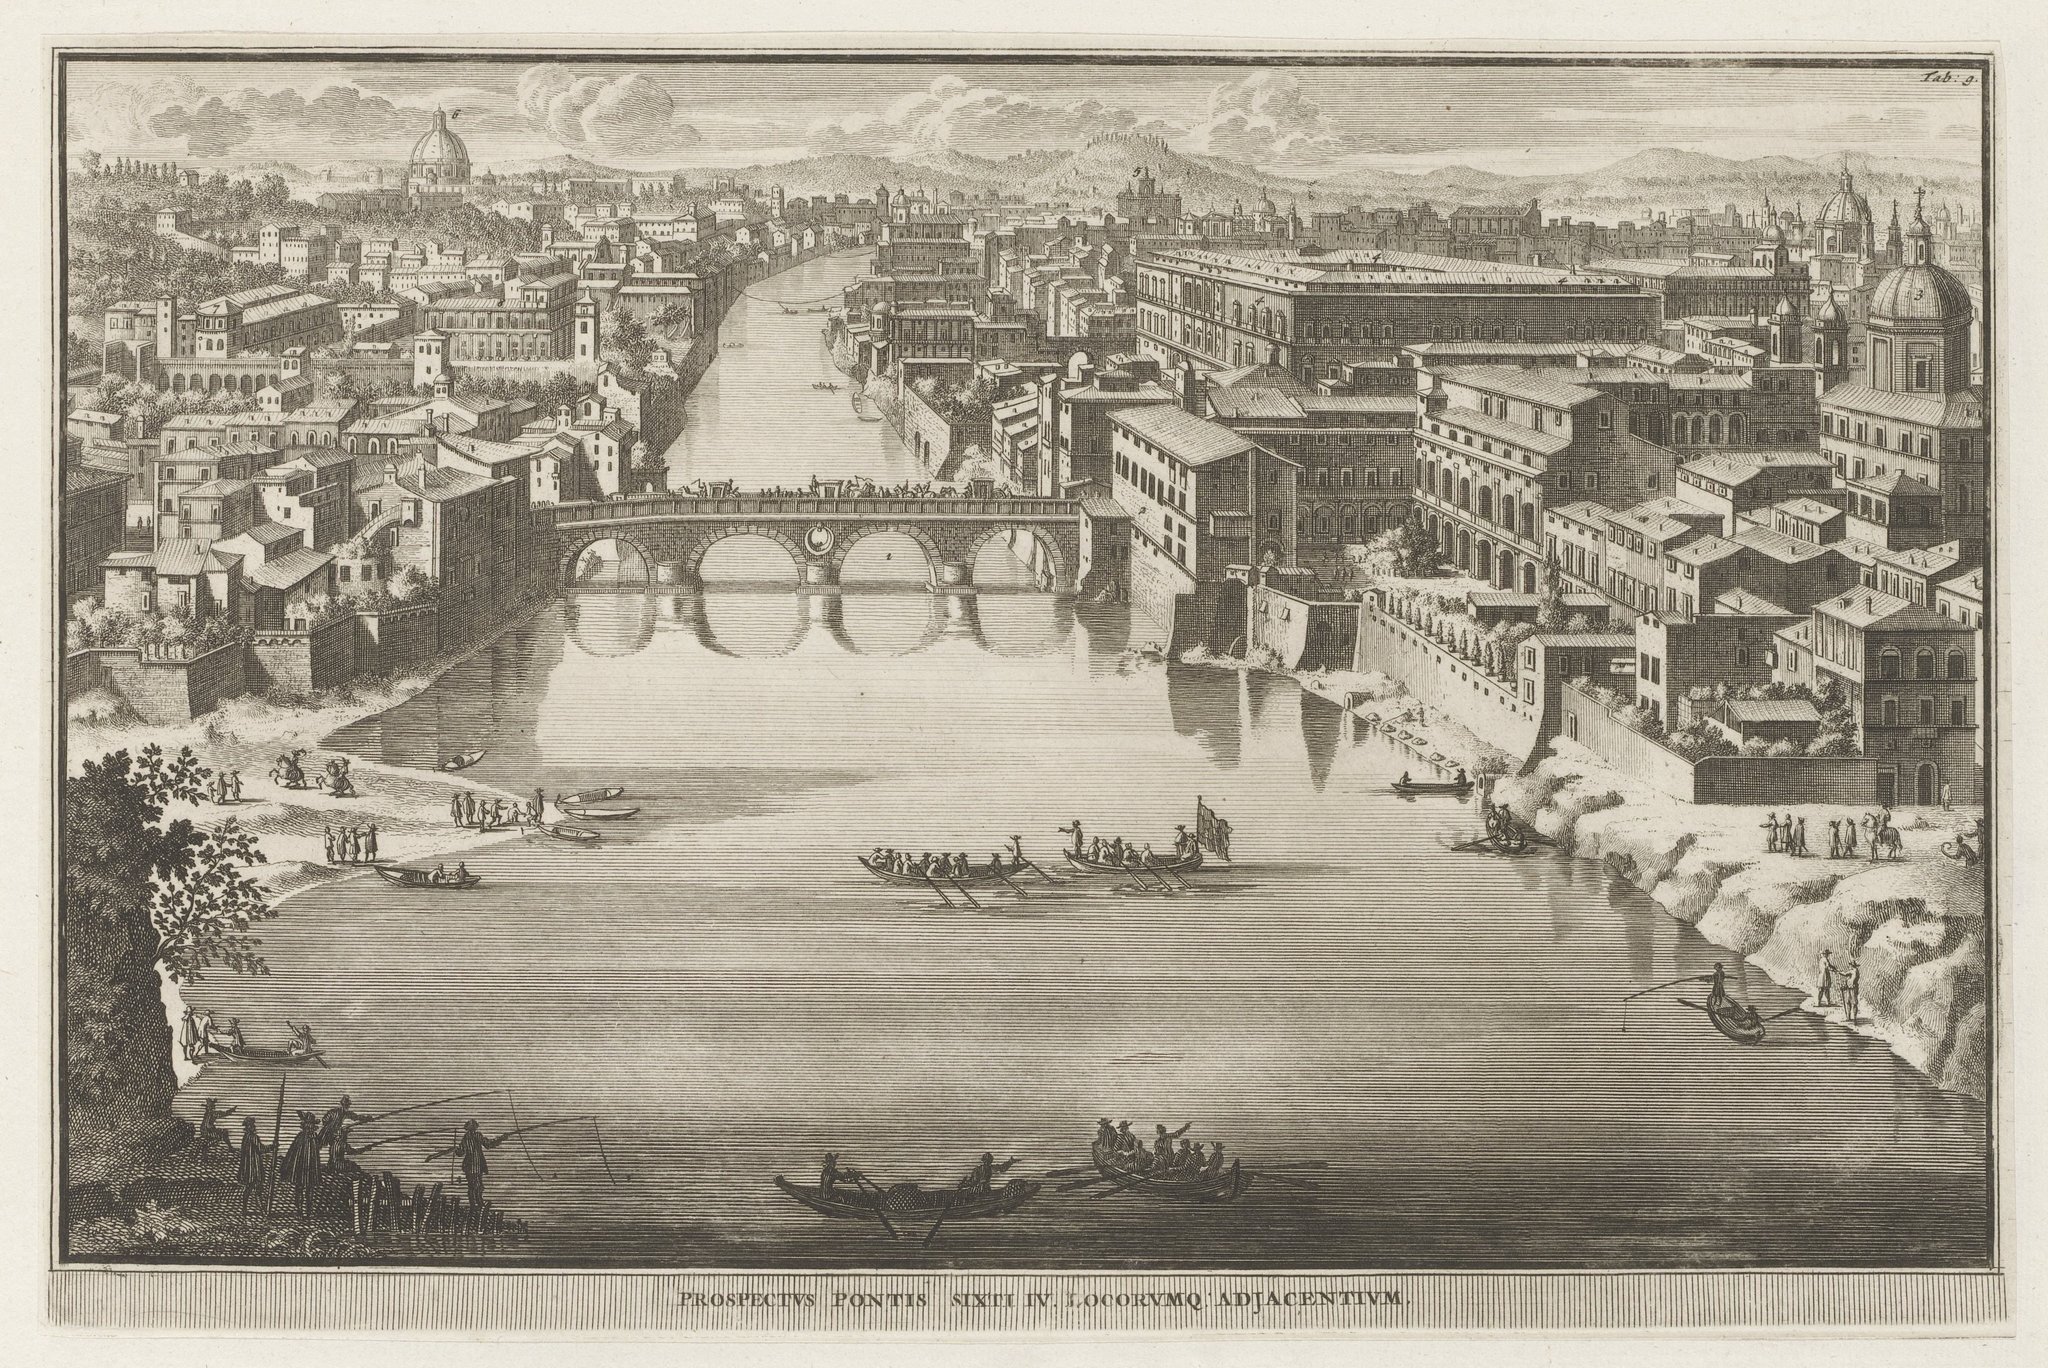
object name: album leaf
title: Gezichten op Rome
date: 1729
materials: paper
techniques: etching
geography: amsterdam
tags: city-view, and landscape with man-made constructions, bridge in city across river, canal, etc.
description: Deze voorstelling is geknipt uit een blad met twee prenten, met in totaal drie voorstellingen. De andere voorstellingen betreffen de tempel voor Santa Maria Solis en het Piazza Santa Maria in Trastevere.